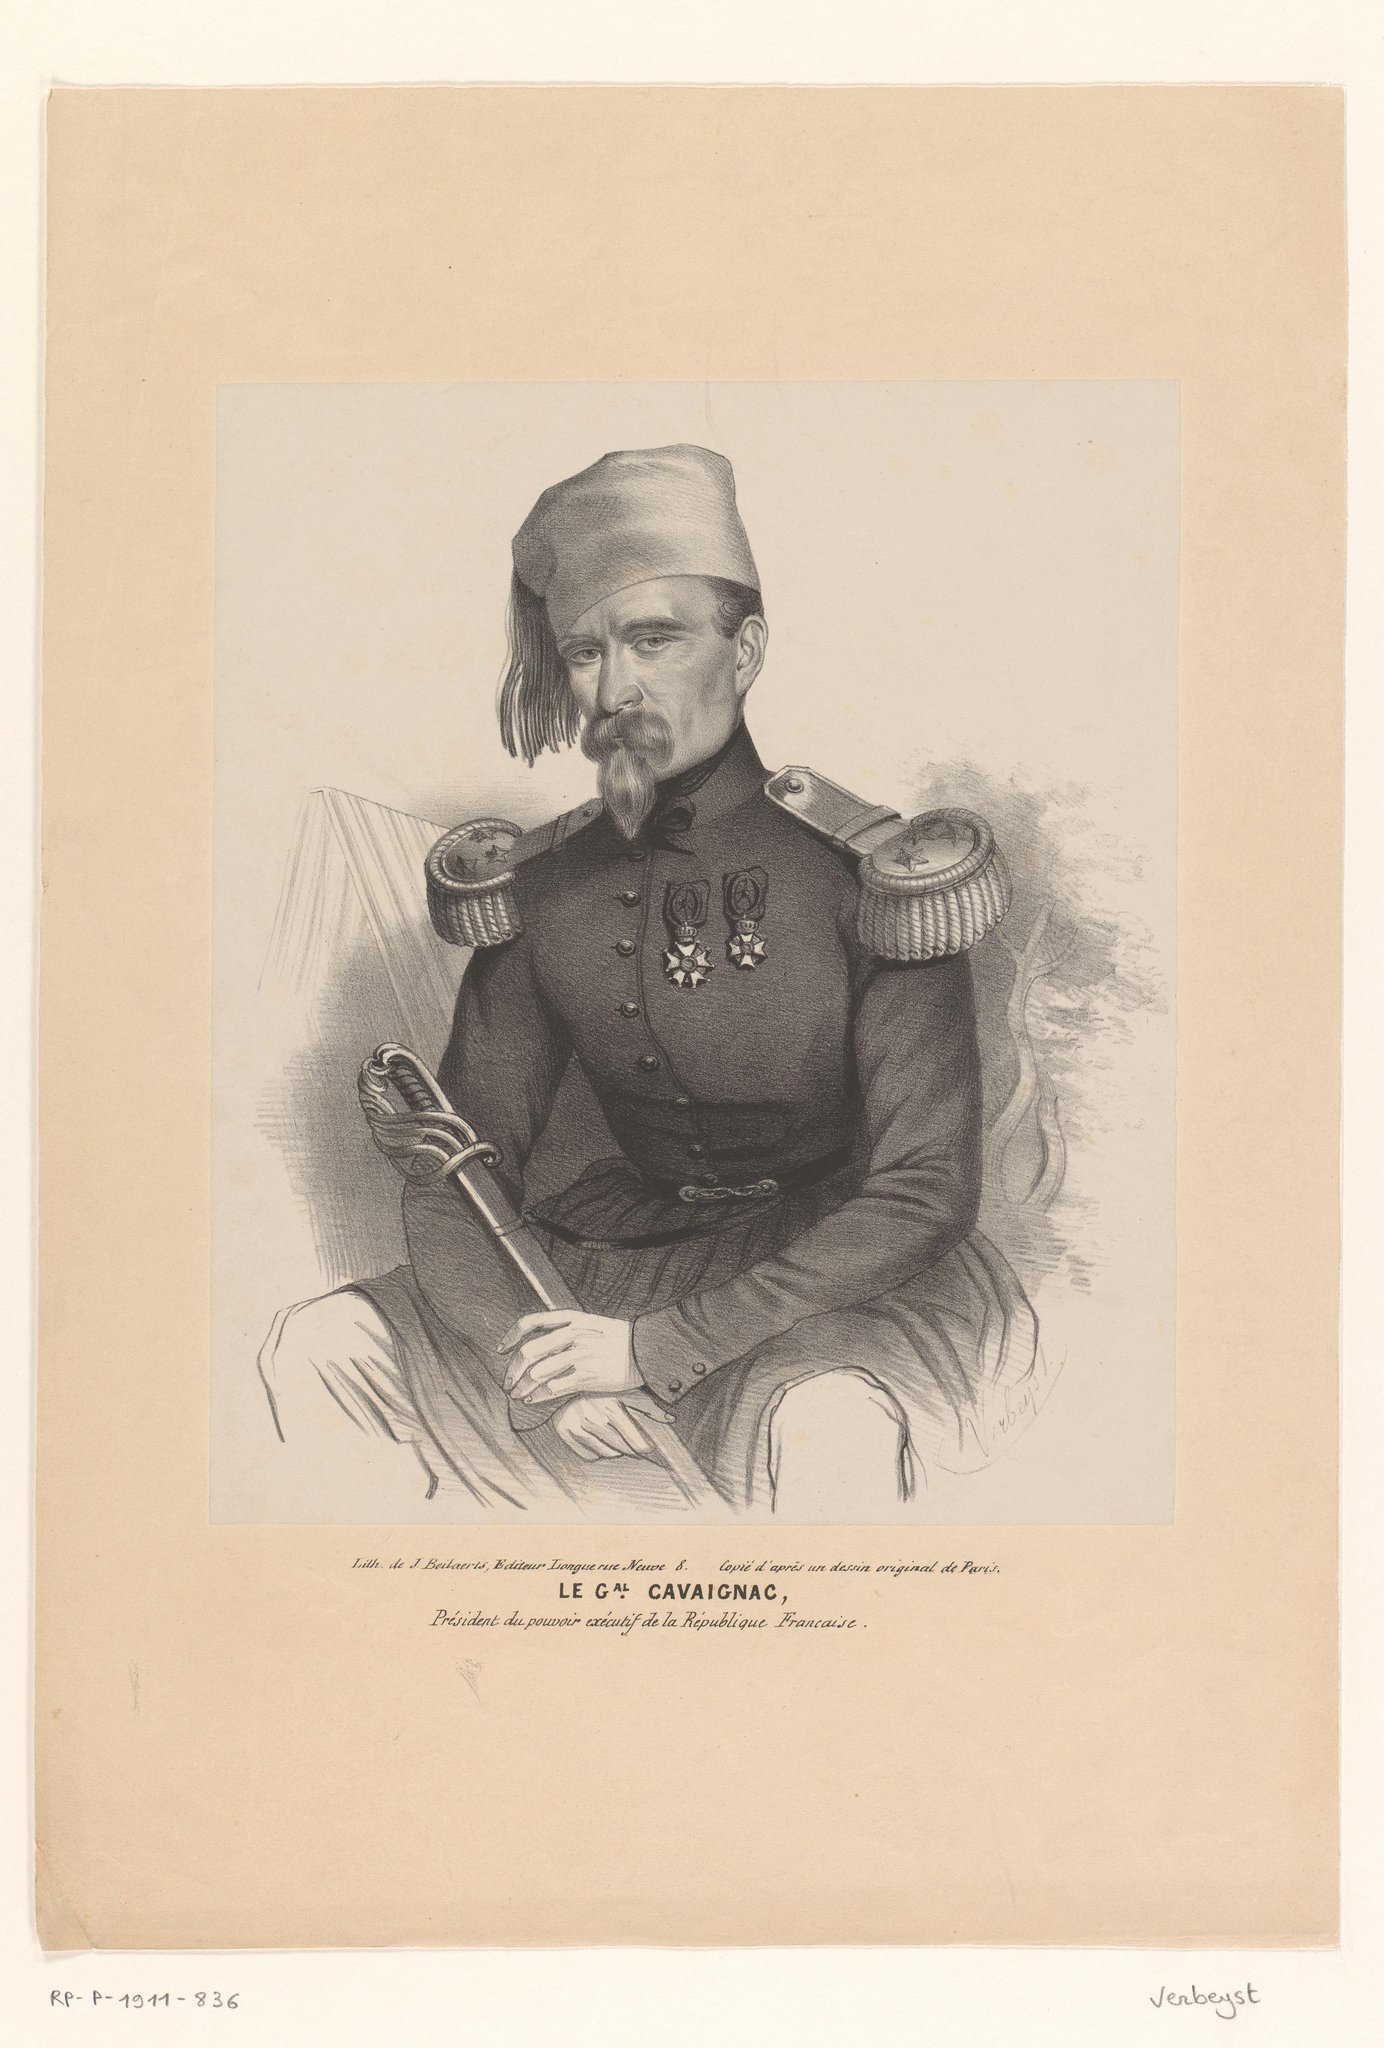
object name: print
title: Le Gal. Cavaignac, président du pouvoir exécutif de la république Francaise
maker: j. beilaerts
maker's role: printer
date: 1830-1911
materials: paper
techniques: lithograph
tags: adult man, historical persons, (military) uniforms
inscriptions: collector's mark: Lugt 2228